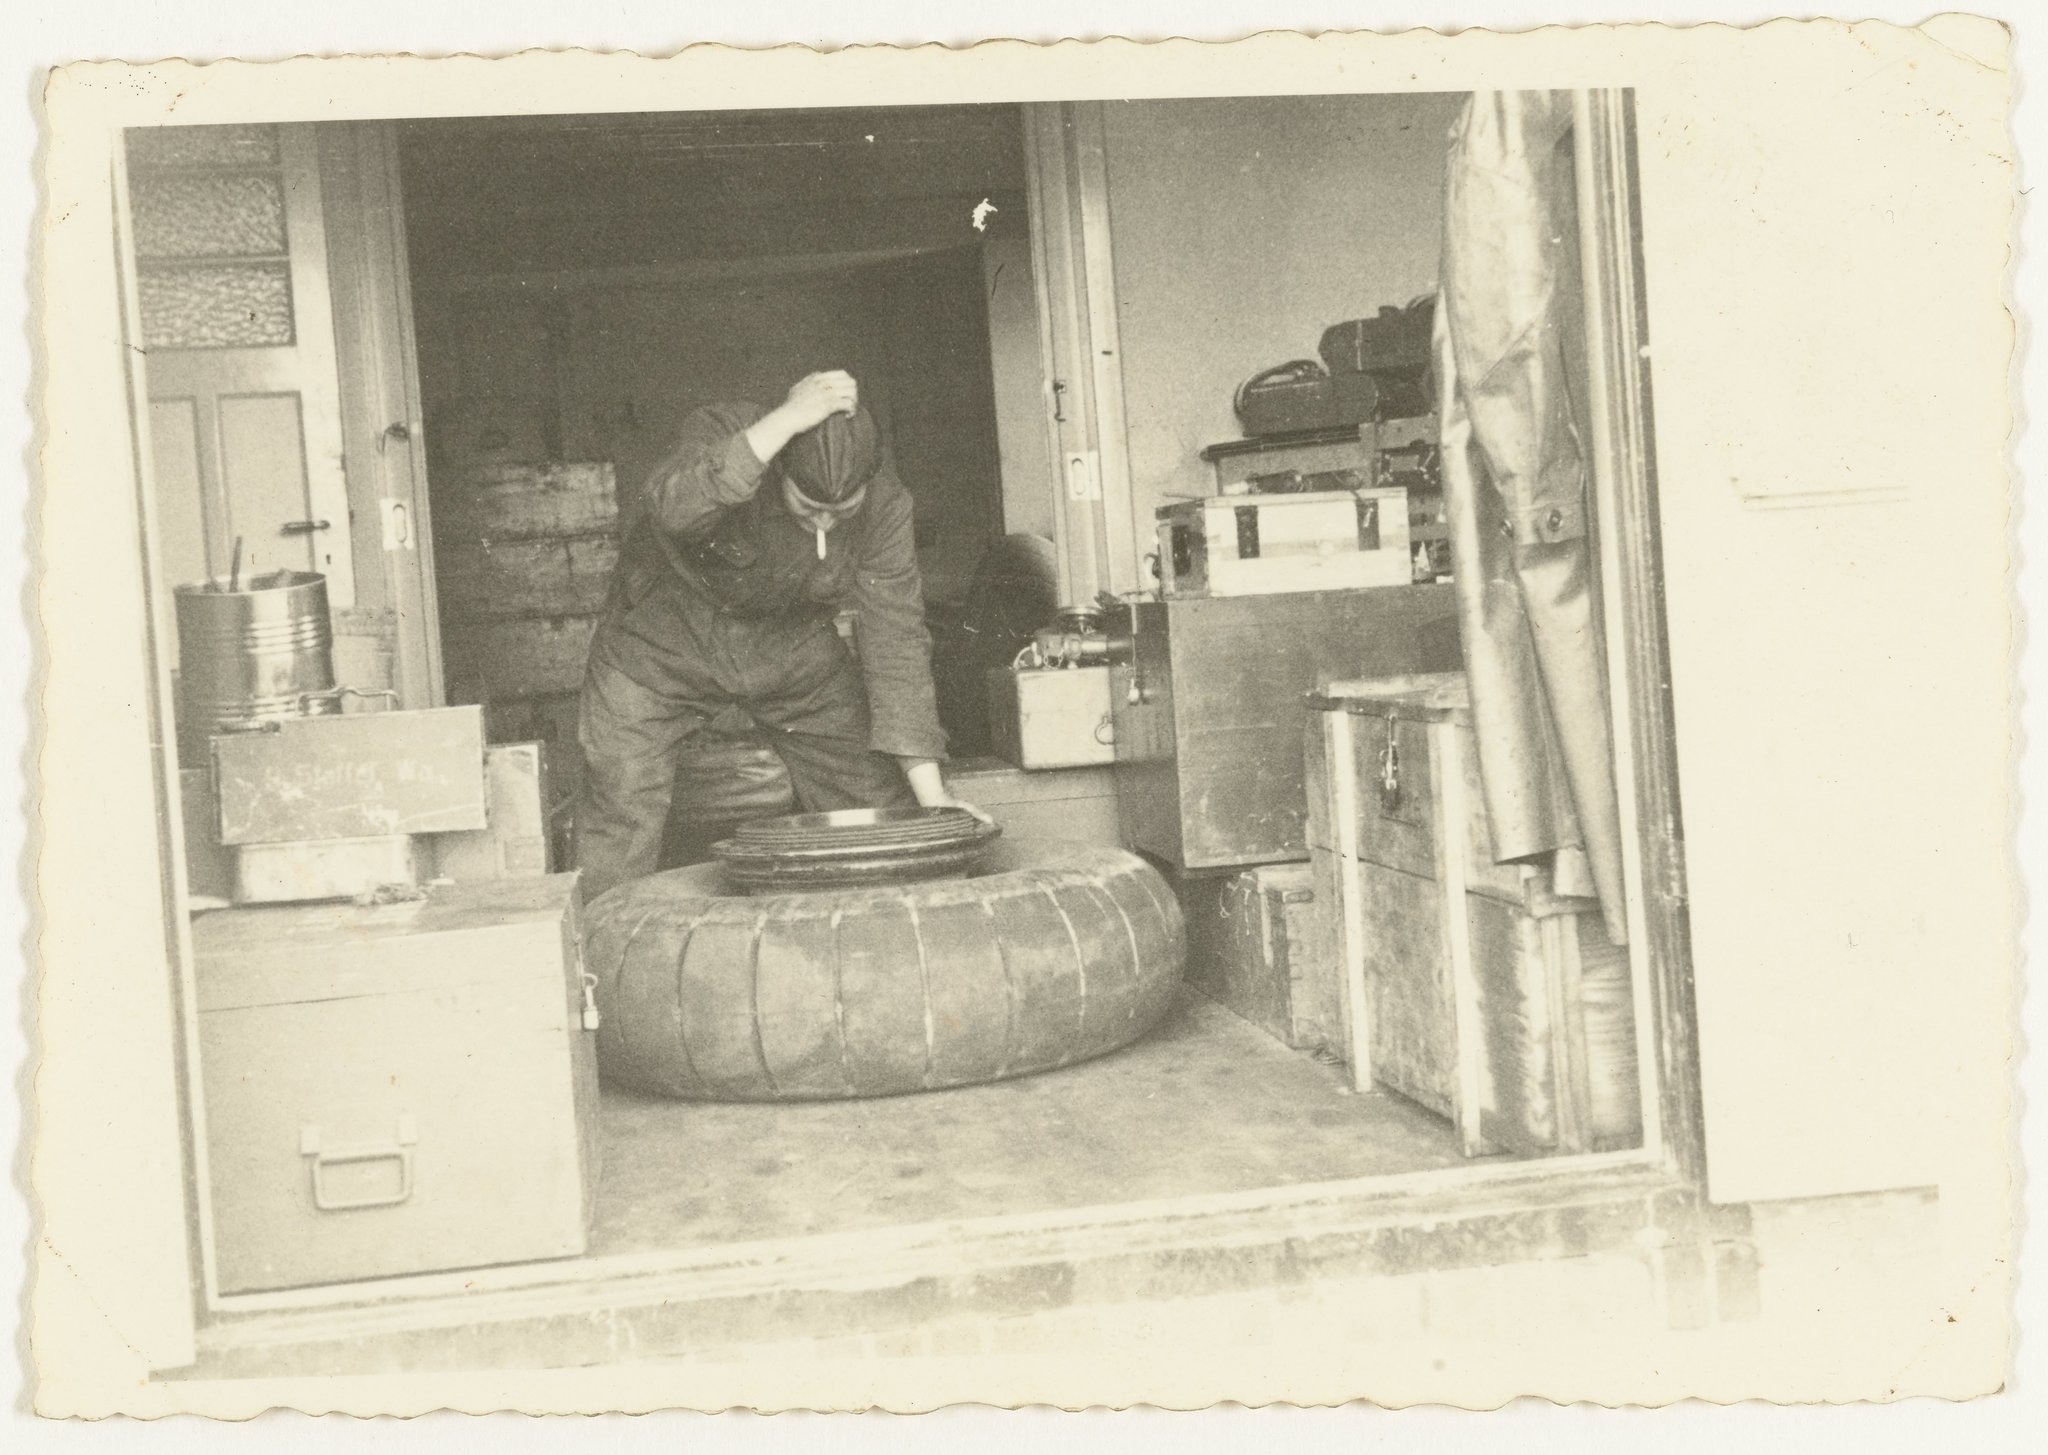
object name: photograph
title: Militair in garage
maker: Anonymous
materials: photographic support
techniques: gelatin silver print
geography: netherlands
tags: repair shop, garage for repairs, supplies etc., occupation ~ war, netherlands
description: Een militair, waarschijnlijk Wehrmacht, is bezig een band te verwisselen. Hij rookt een sigaret. Achterop staat: .......(Holland) beim Reifen ab......